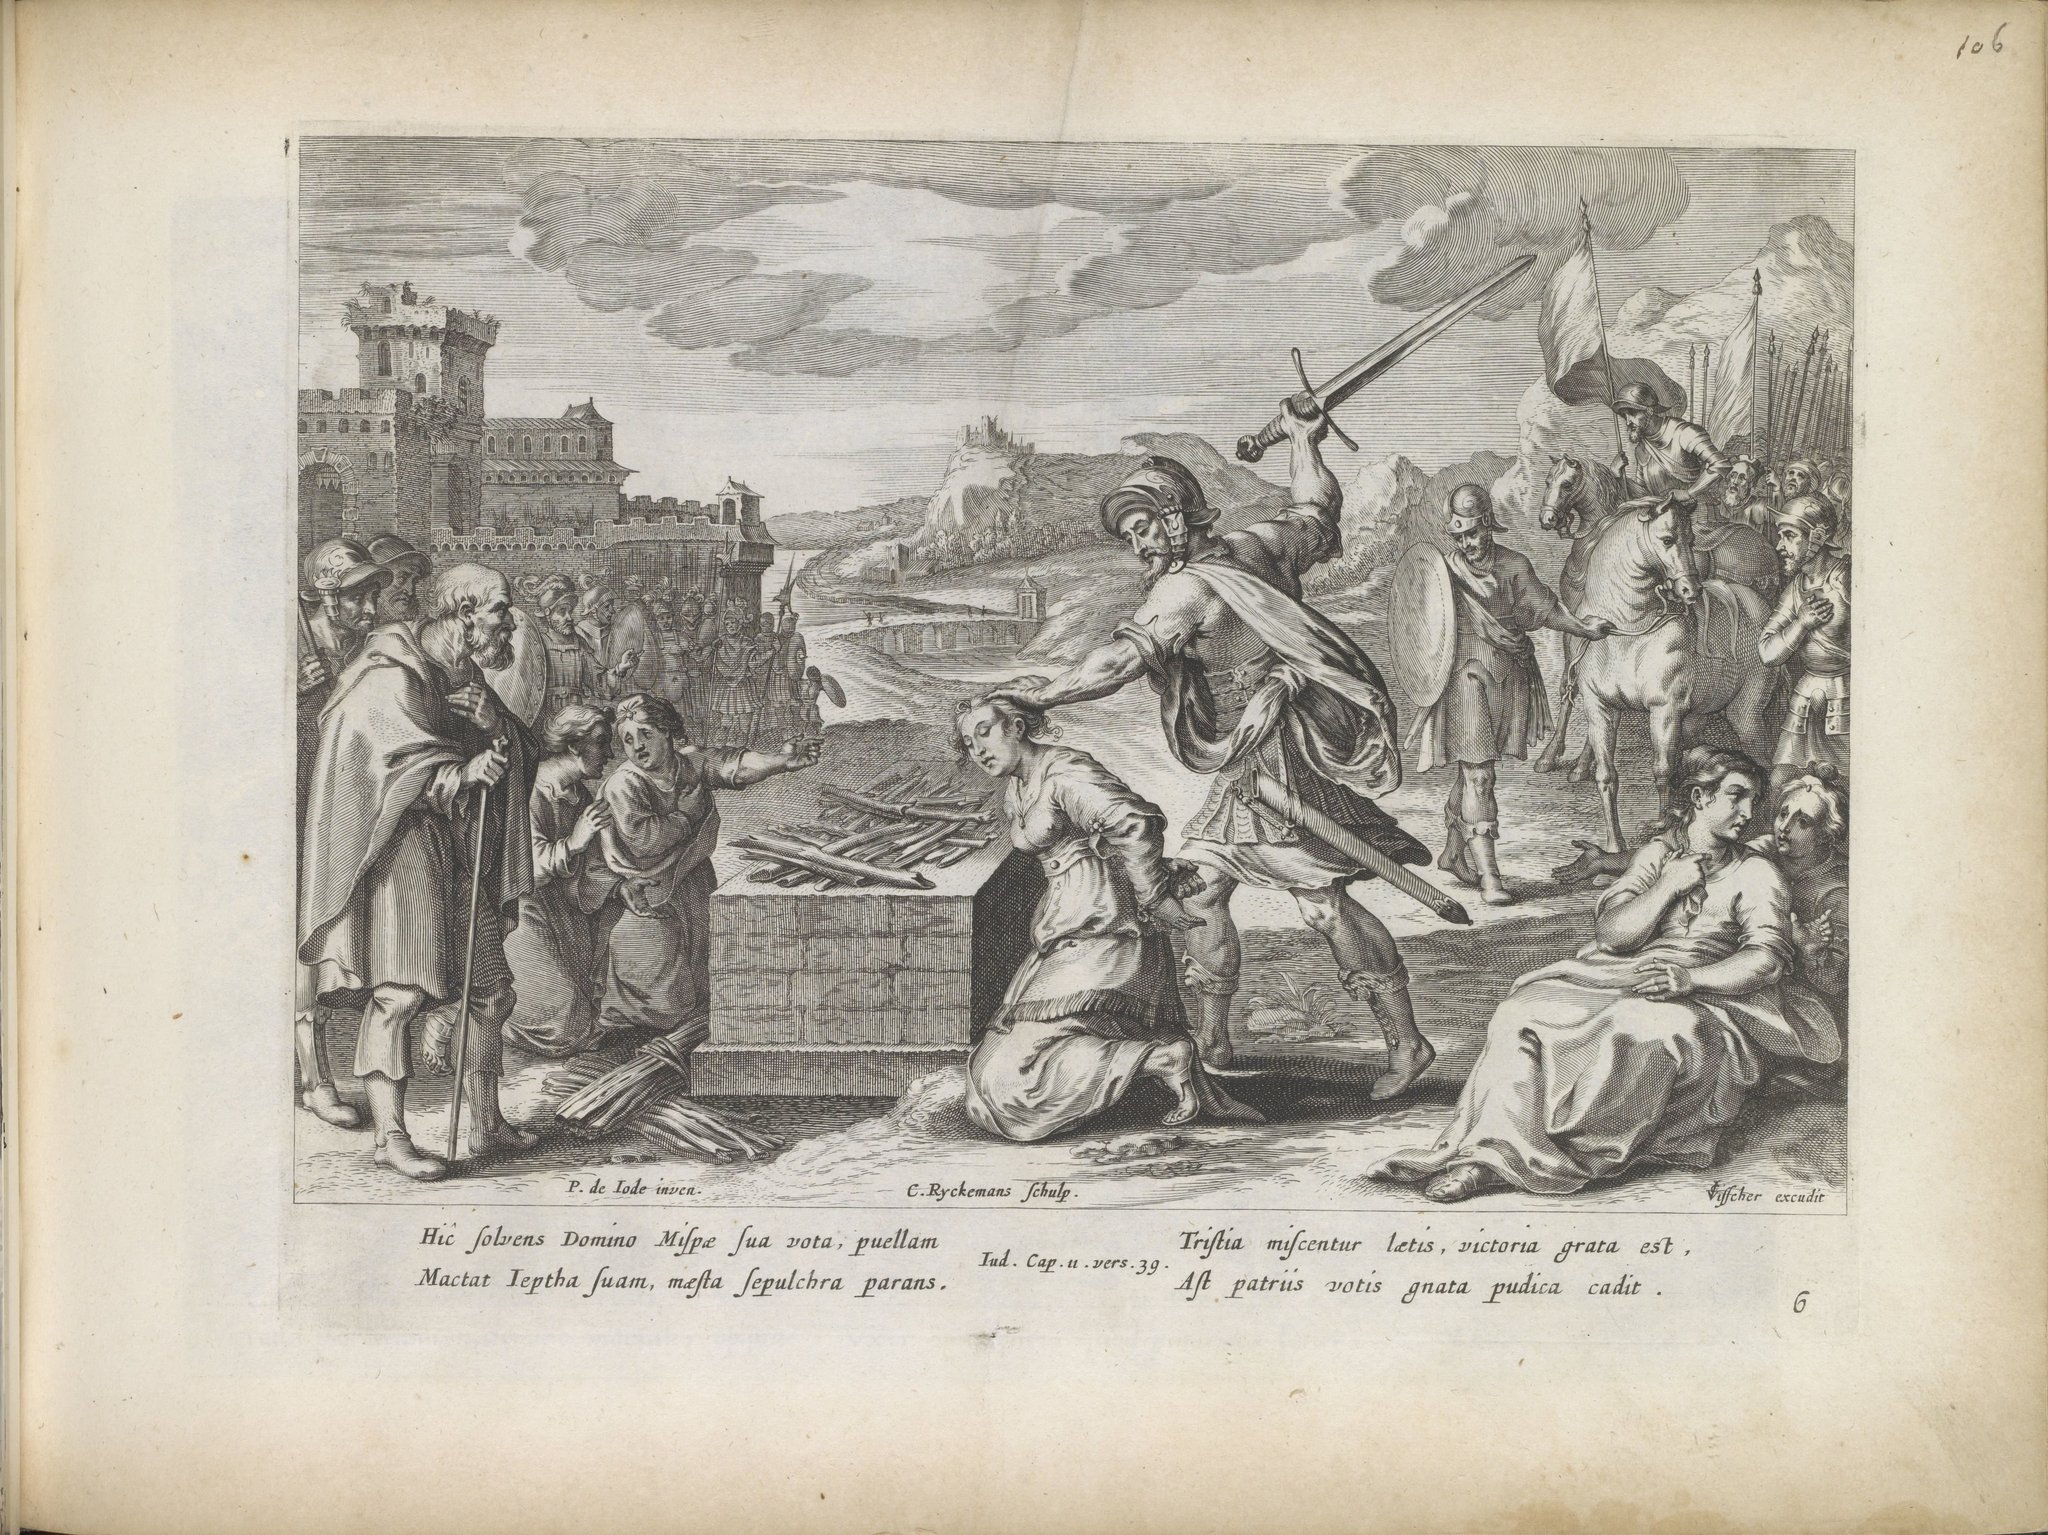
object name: print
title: Jefta offert zijn dochter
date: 1616-1636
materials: paper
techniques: engraving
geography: amsterdam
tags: fulfilment of jephthah's vow to the lord: jephthah's daughter is sacrificed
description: Onder toeziend oog van een schare mensen offert Jefta zijn dochter, waarmee hij zijn belofte aan God inlost. Onder de voorstelling een verwijzing in het Latijn naar de Bijbeltekst in Ri. 11:39. Deze prent maakt deel uit van een album.